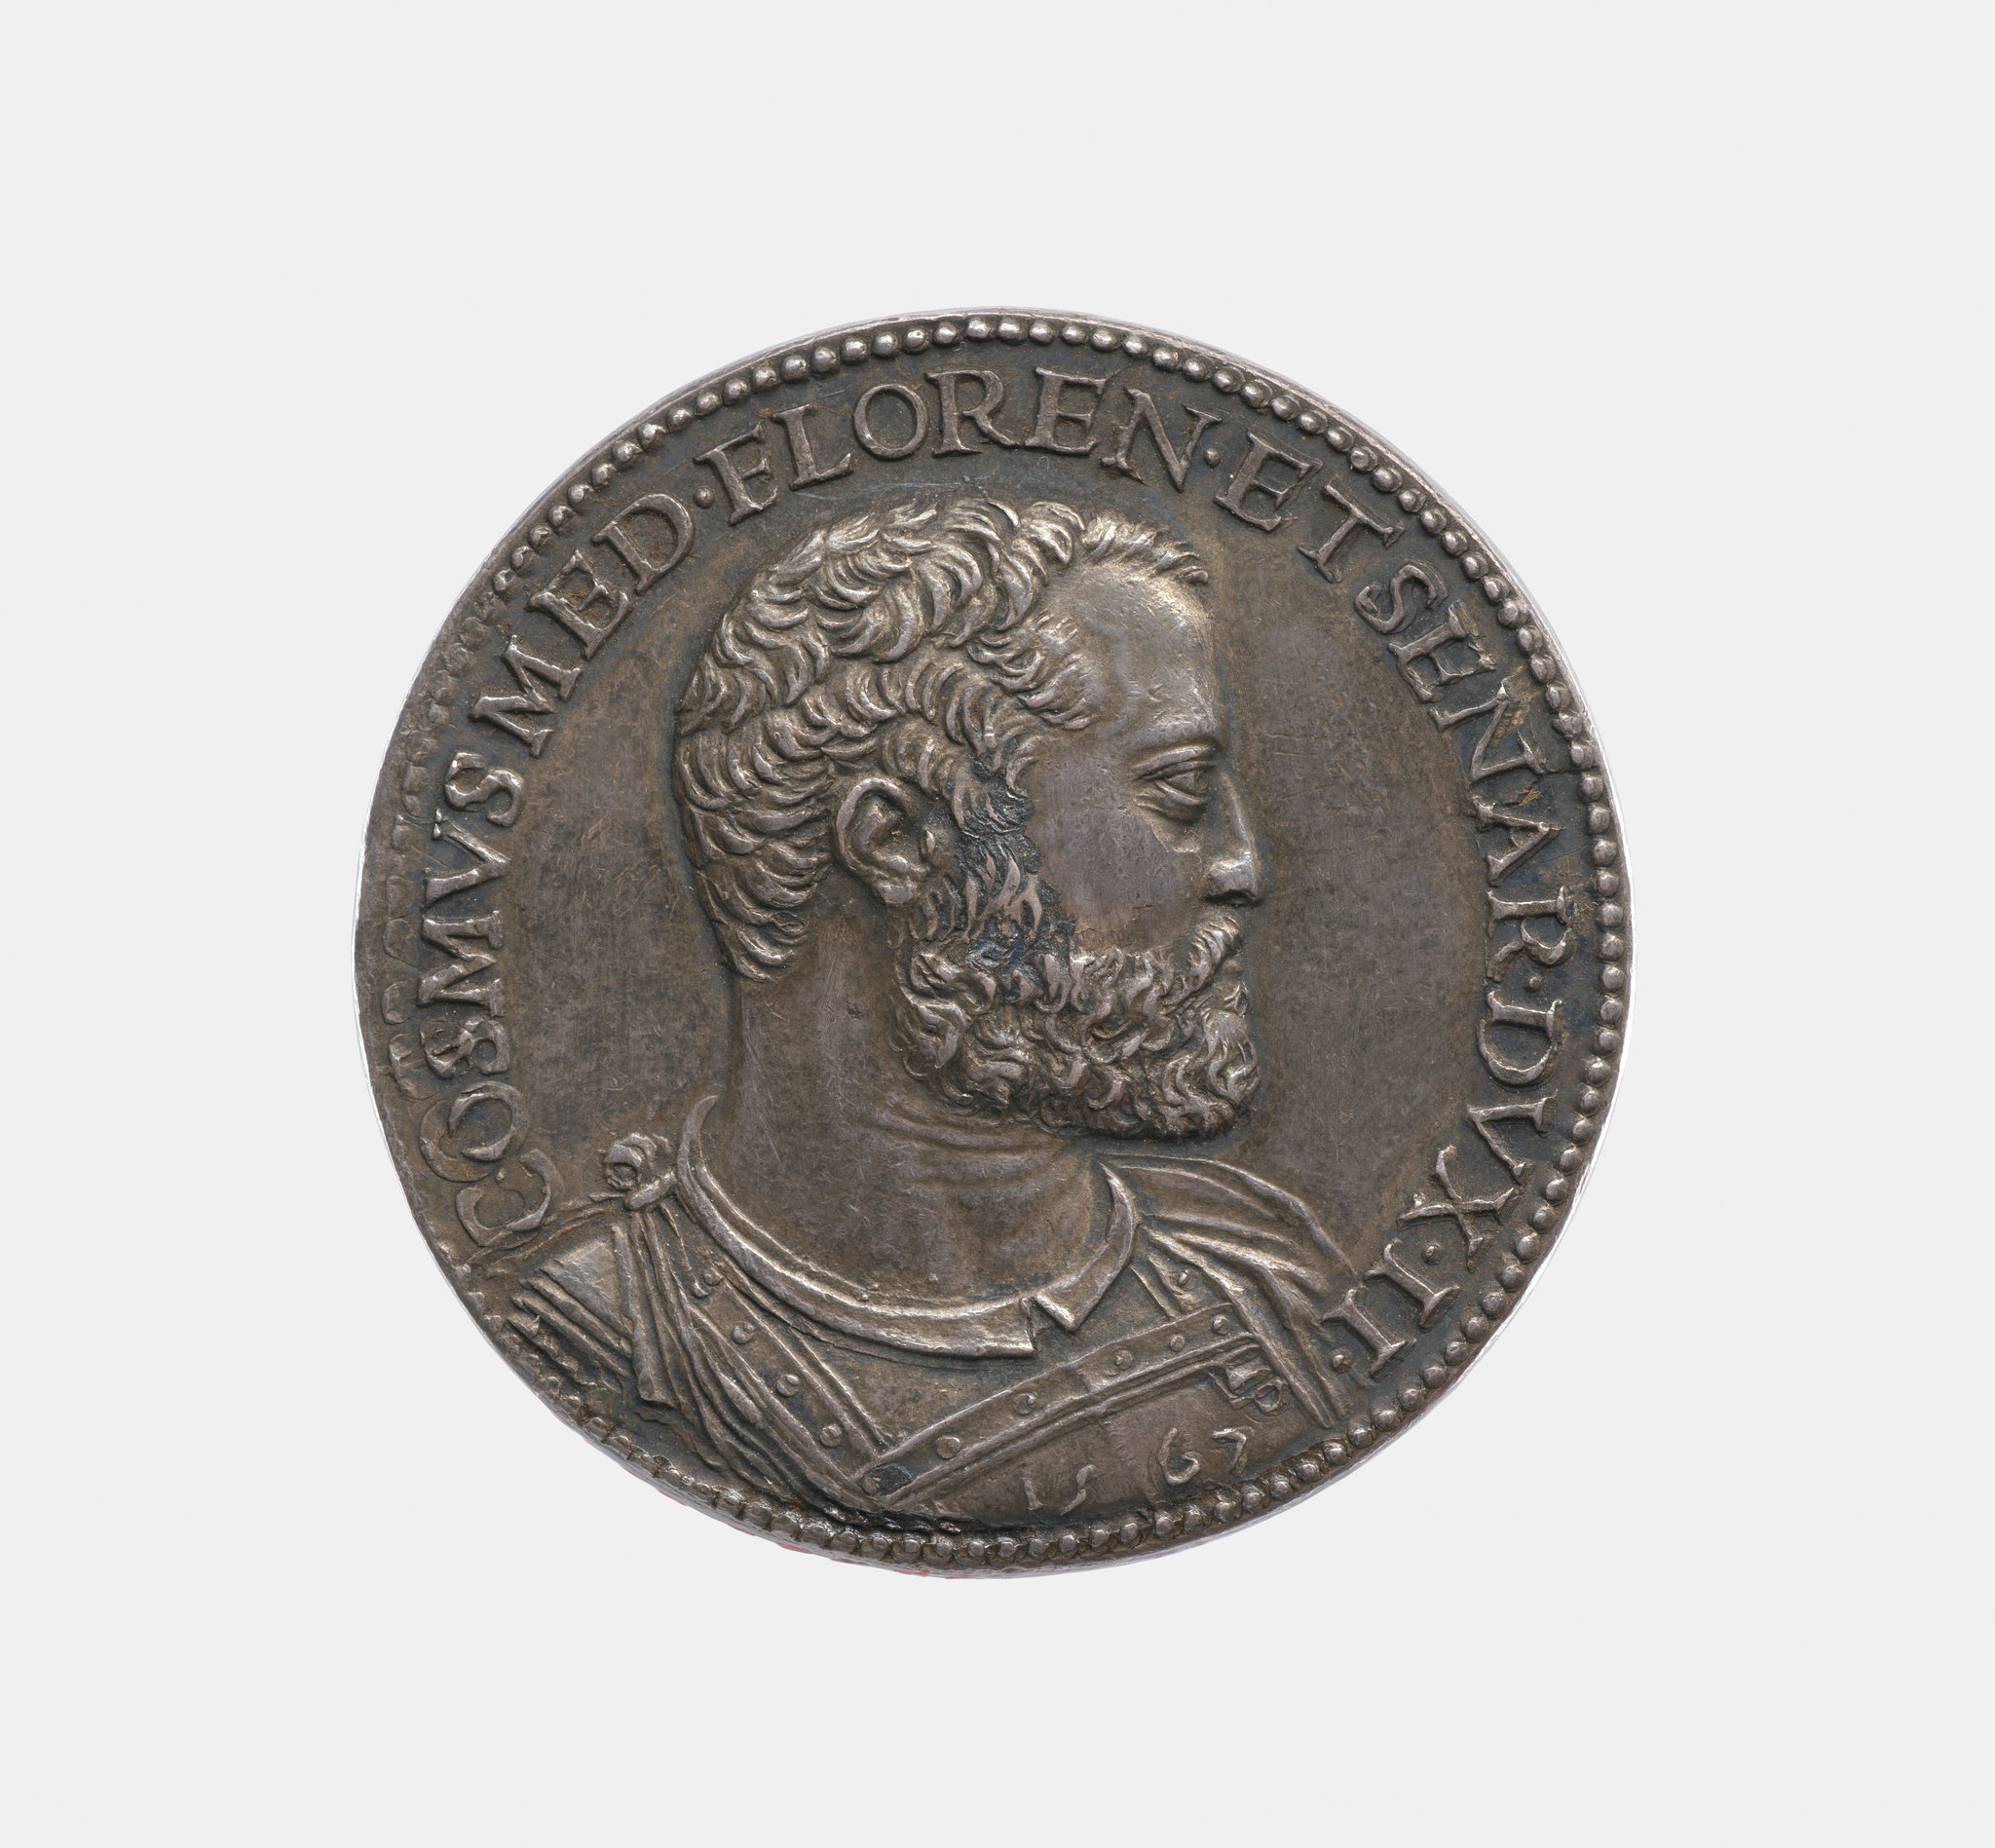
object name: medal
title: Cosimo I de' Medici 1519-74, Duke of Florence 1537-69, Grand Duke of Tuscany 1569-74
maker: domenico poggini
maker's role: artist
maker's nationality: italian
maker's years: 1520-1590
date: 1567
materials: silver